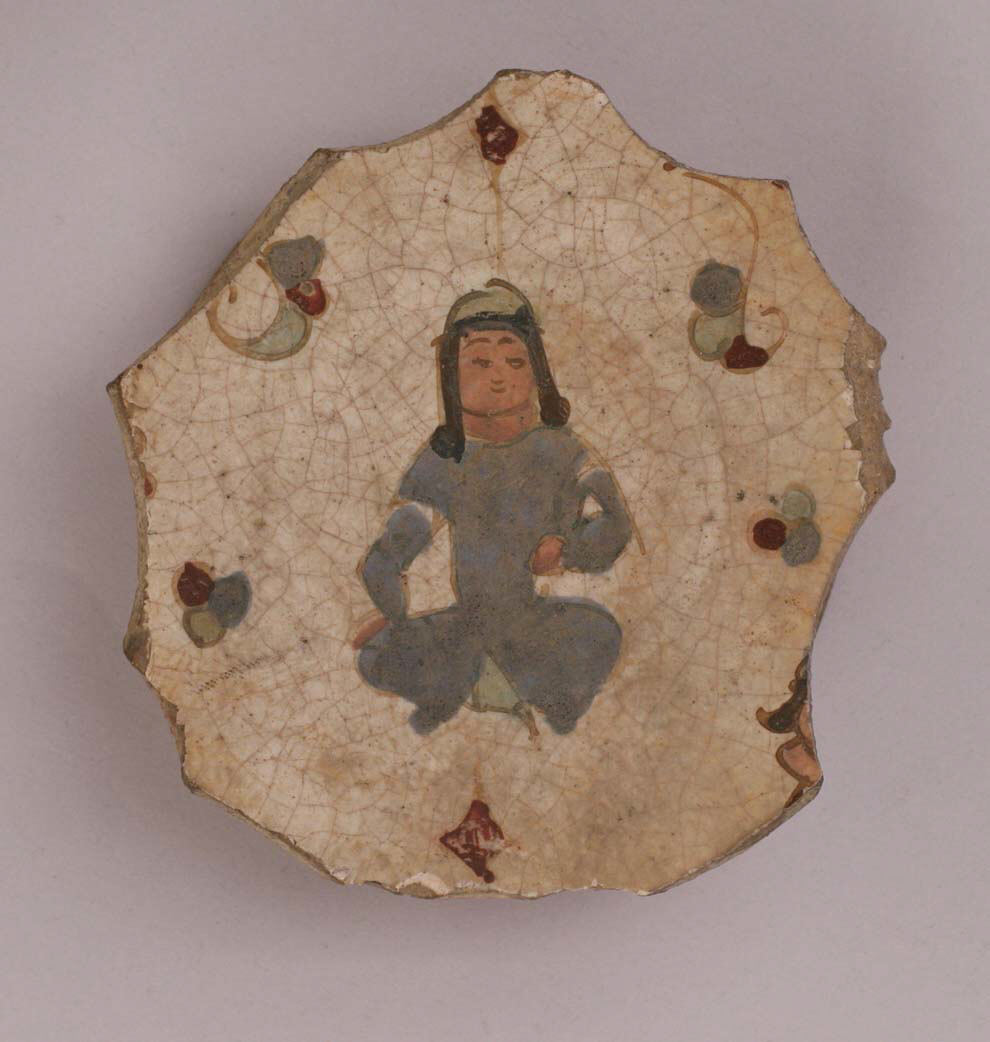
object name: fragment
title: Fragment of a Bowl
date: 1101-1300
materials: stonepaste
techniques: overglaze, painting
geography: iran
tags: men